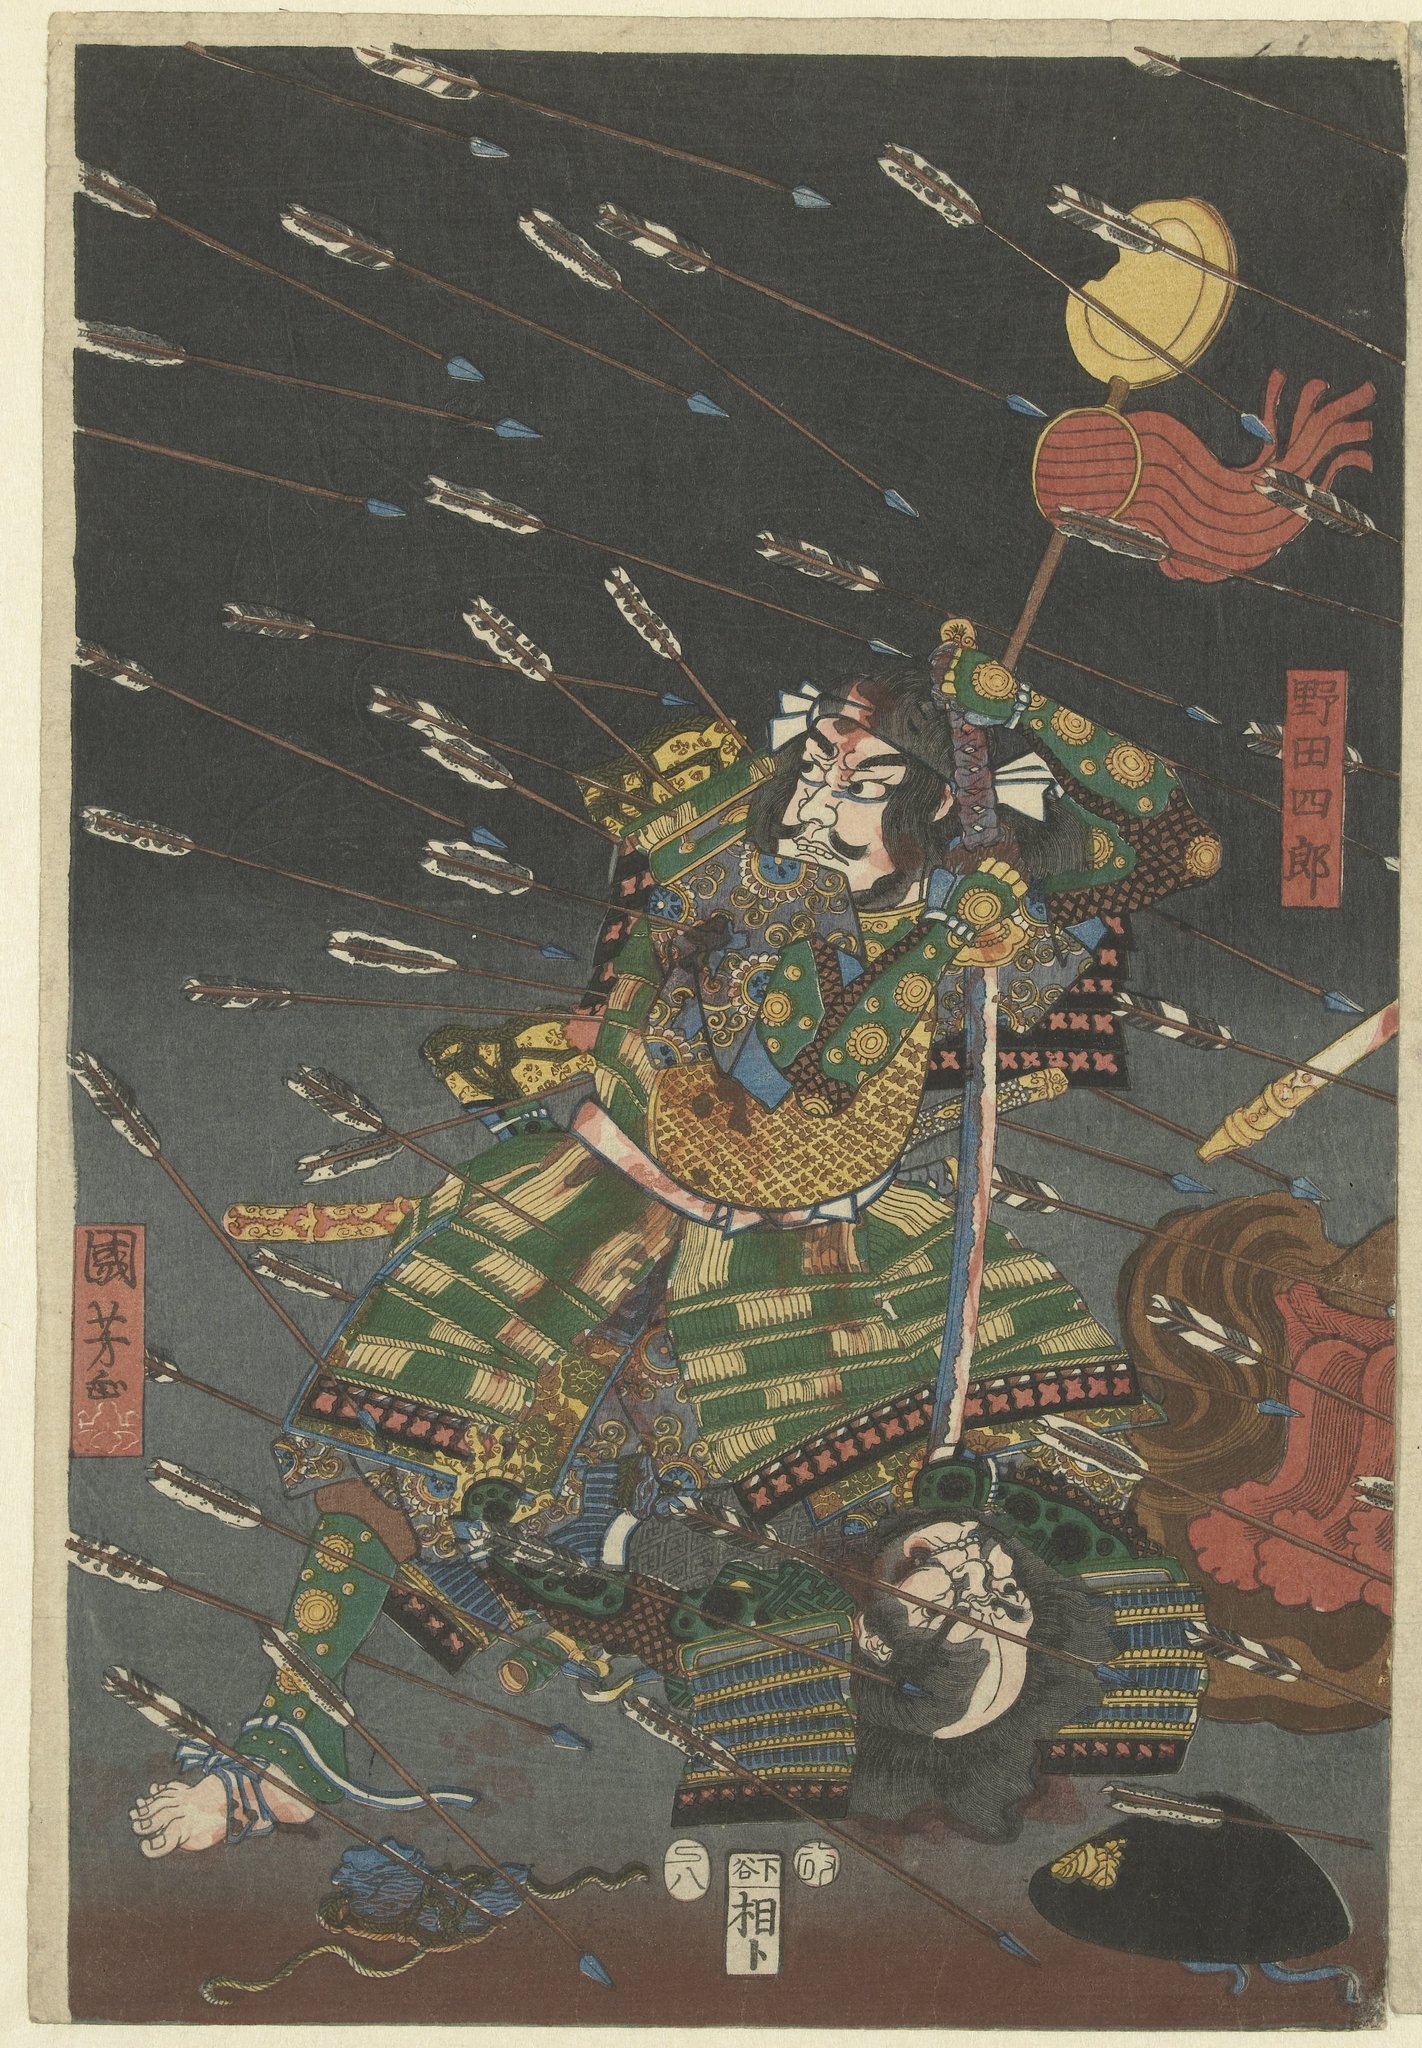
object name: print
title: De laatste aanval van de Kusunoki te Shijonawate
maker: utagawa kuniyoshi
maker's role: draughtsman, print maker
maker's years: 1798-1861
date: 1847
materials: paper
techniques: woodcut, nishiki e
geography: japan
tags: battle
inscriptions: collector's mark: Lugt 2760, collector's mark: Lugt 2228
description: Krijger van de Kusunoki clan, een tegenstander dodend met zwaard, tijdens een pijlenregen afkomstig van de Ashikaga troepen te Shijonawate.